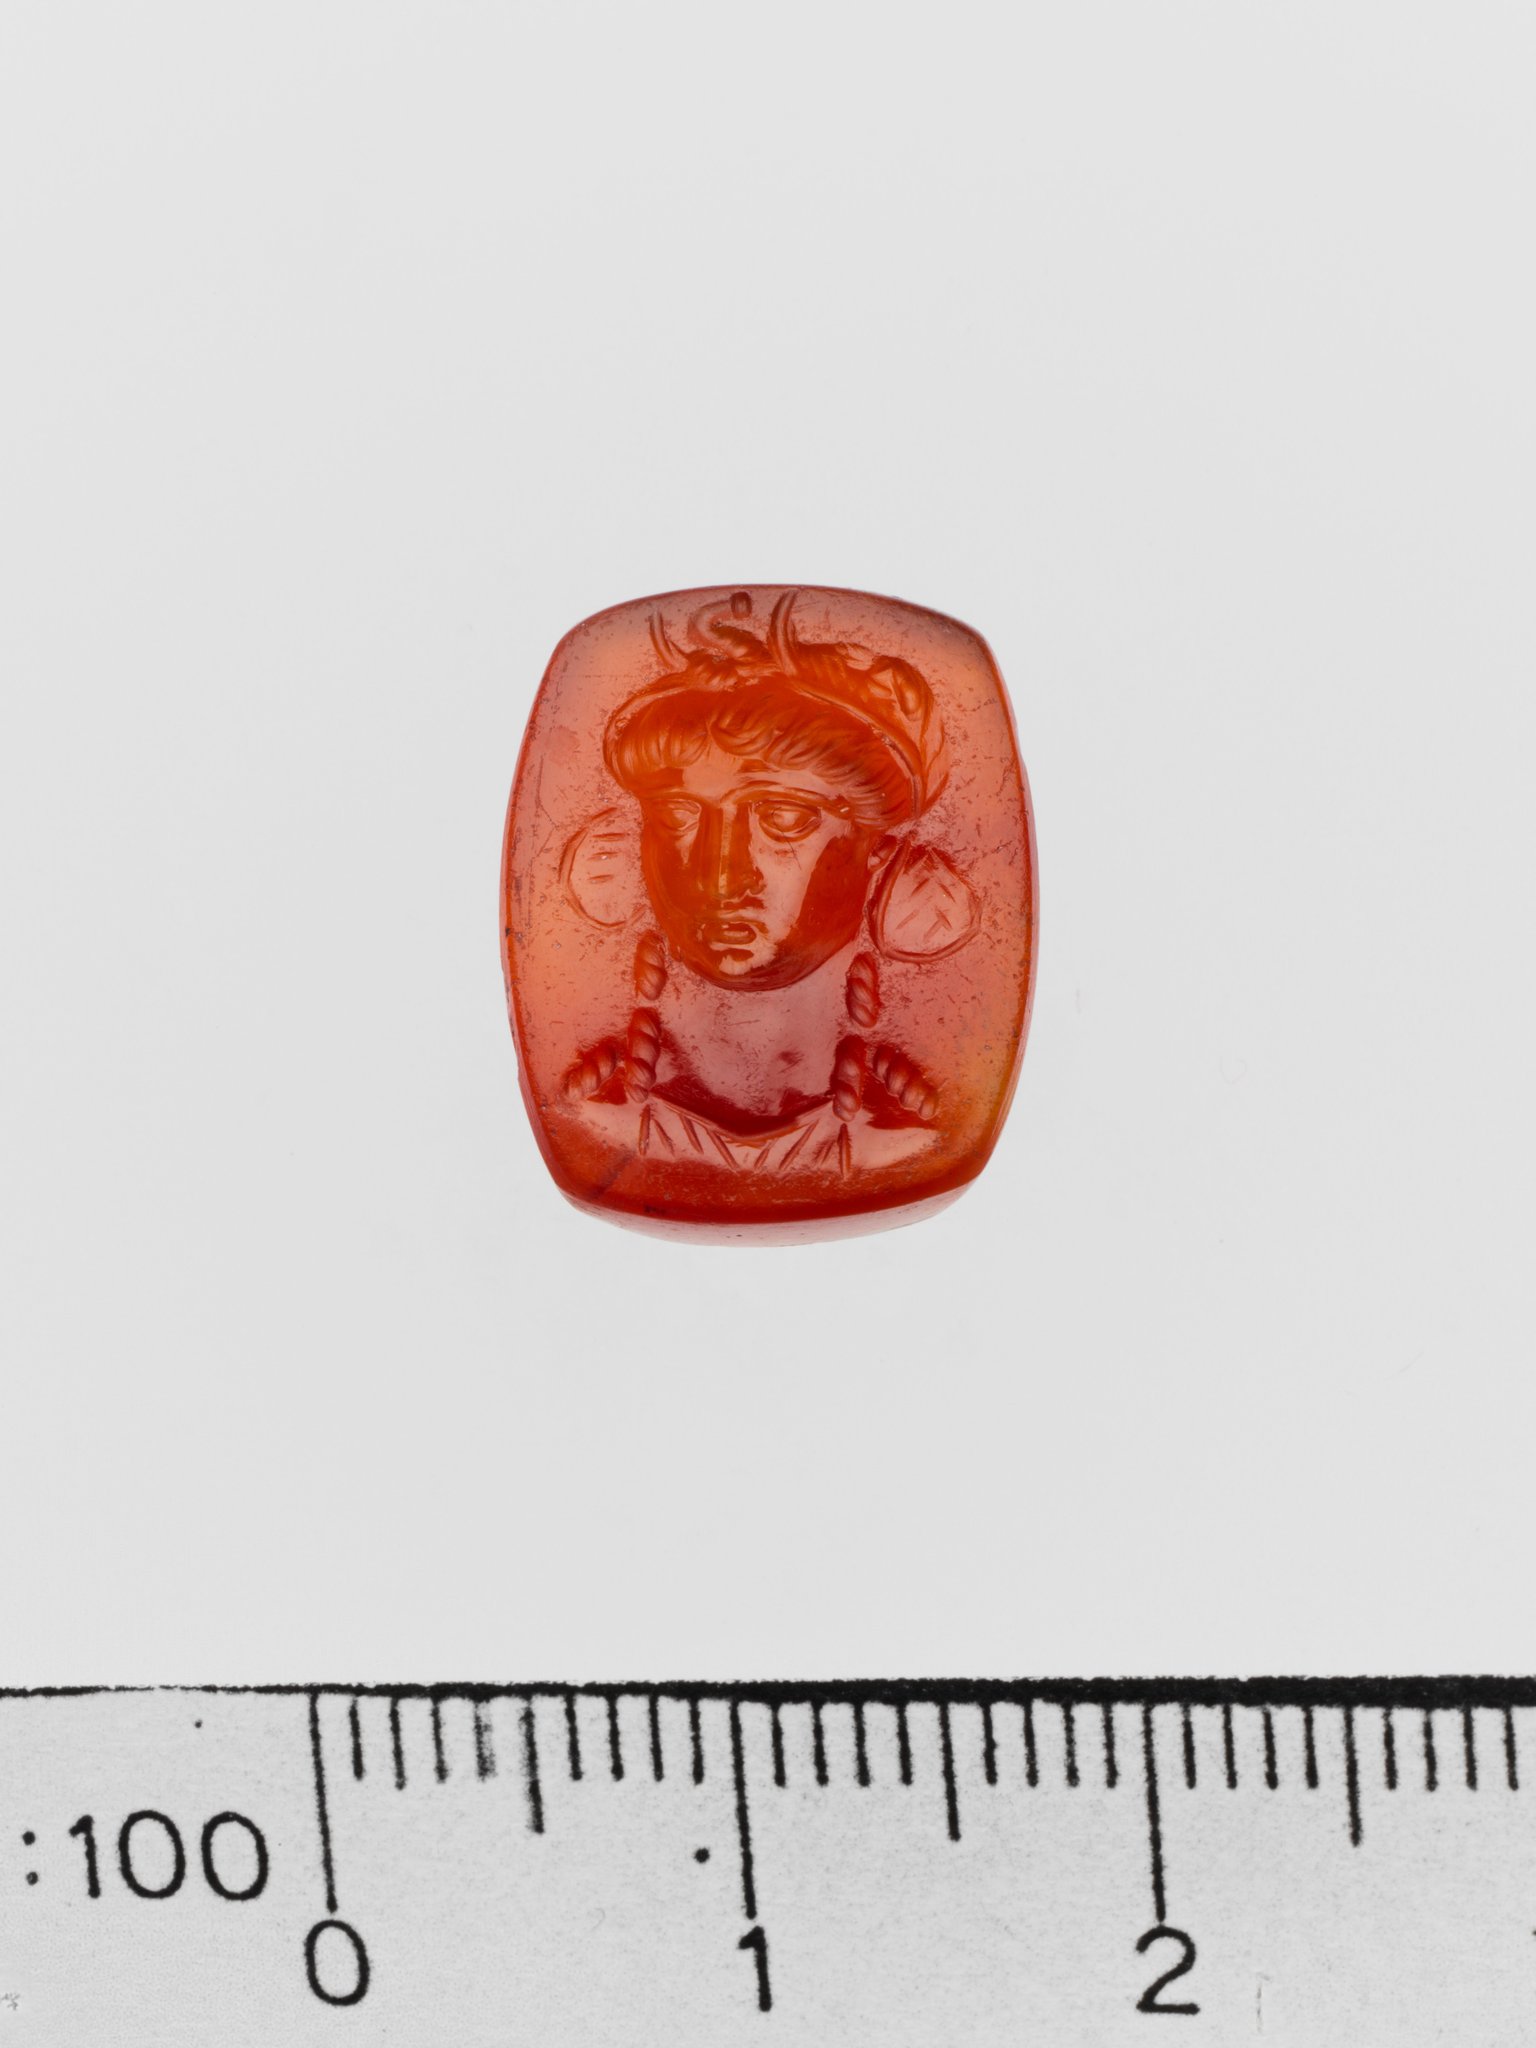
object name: intaglio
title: Carnelian ring stone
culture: roman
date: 1-100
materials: gemstone